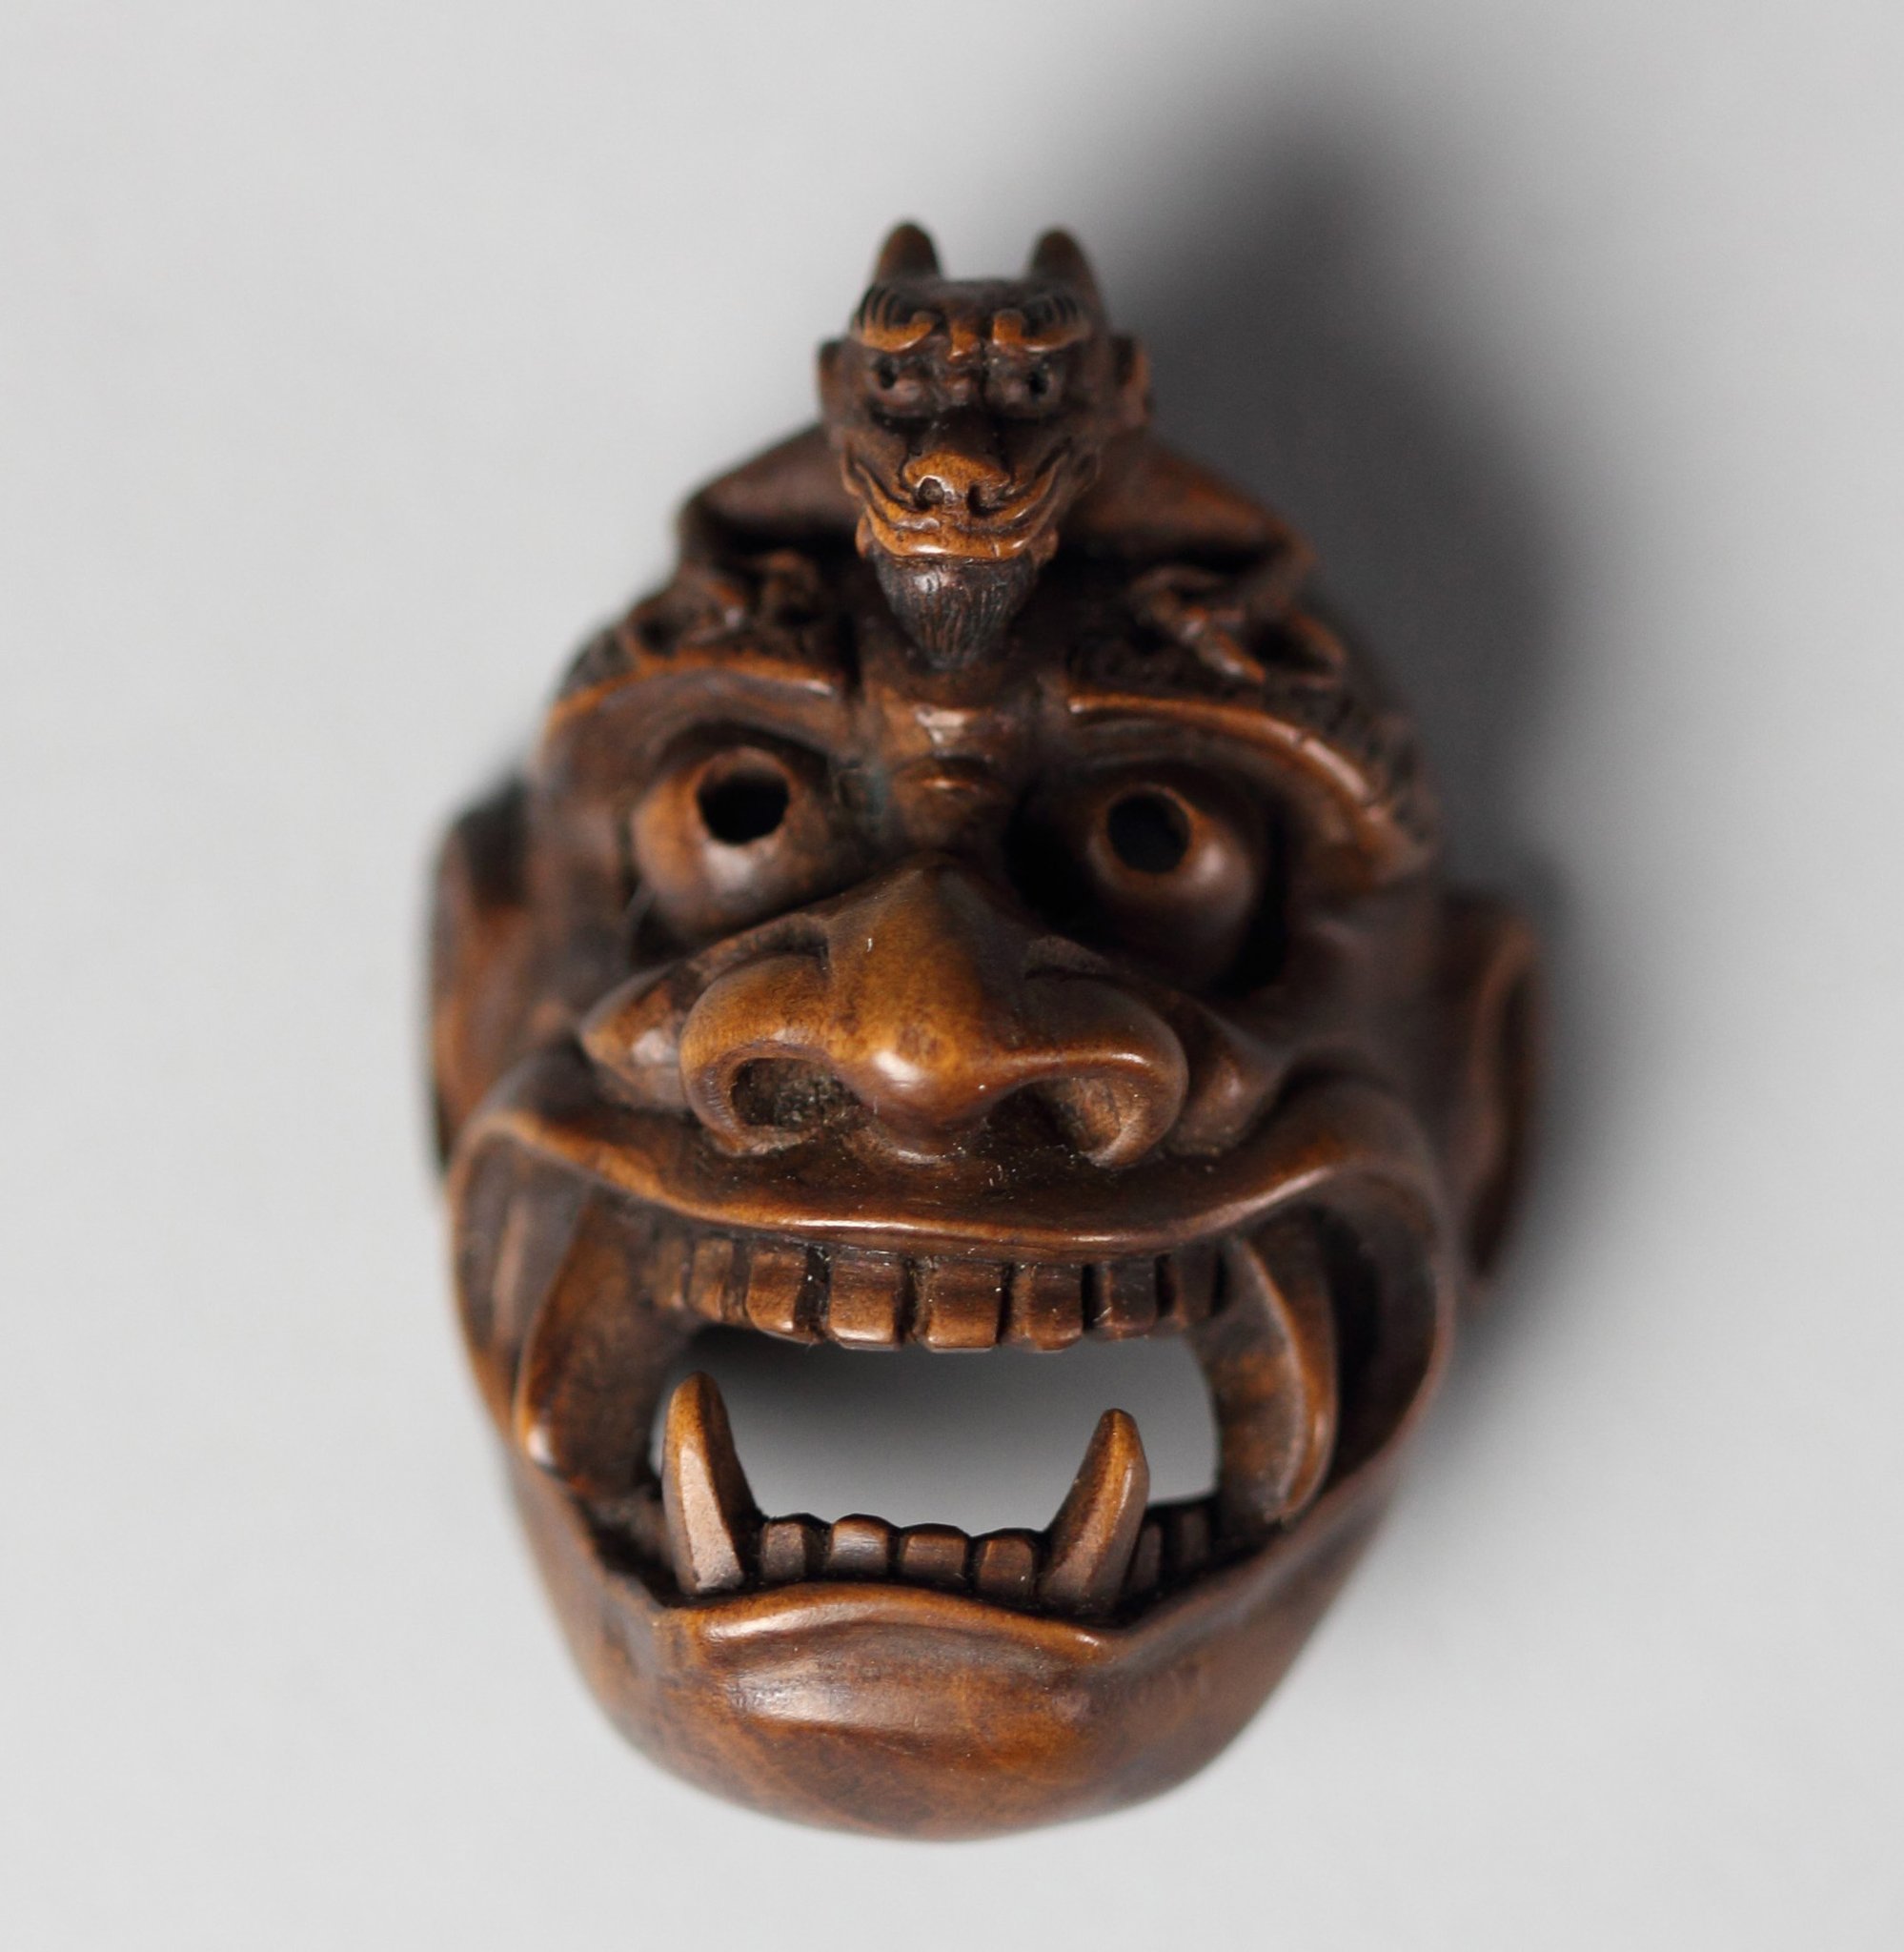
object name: netsuke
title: Netsuke of Demon Mask Derived from Bugaku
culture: japanese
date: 1801-1900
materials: wood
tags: masks,demons